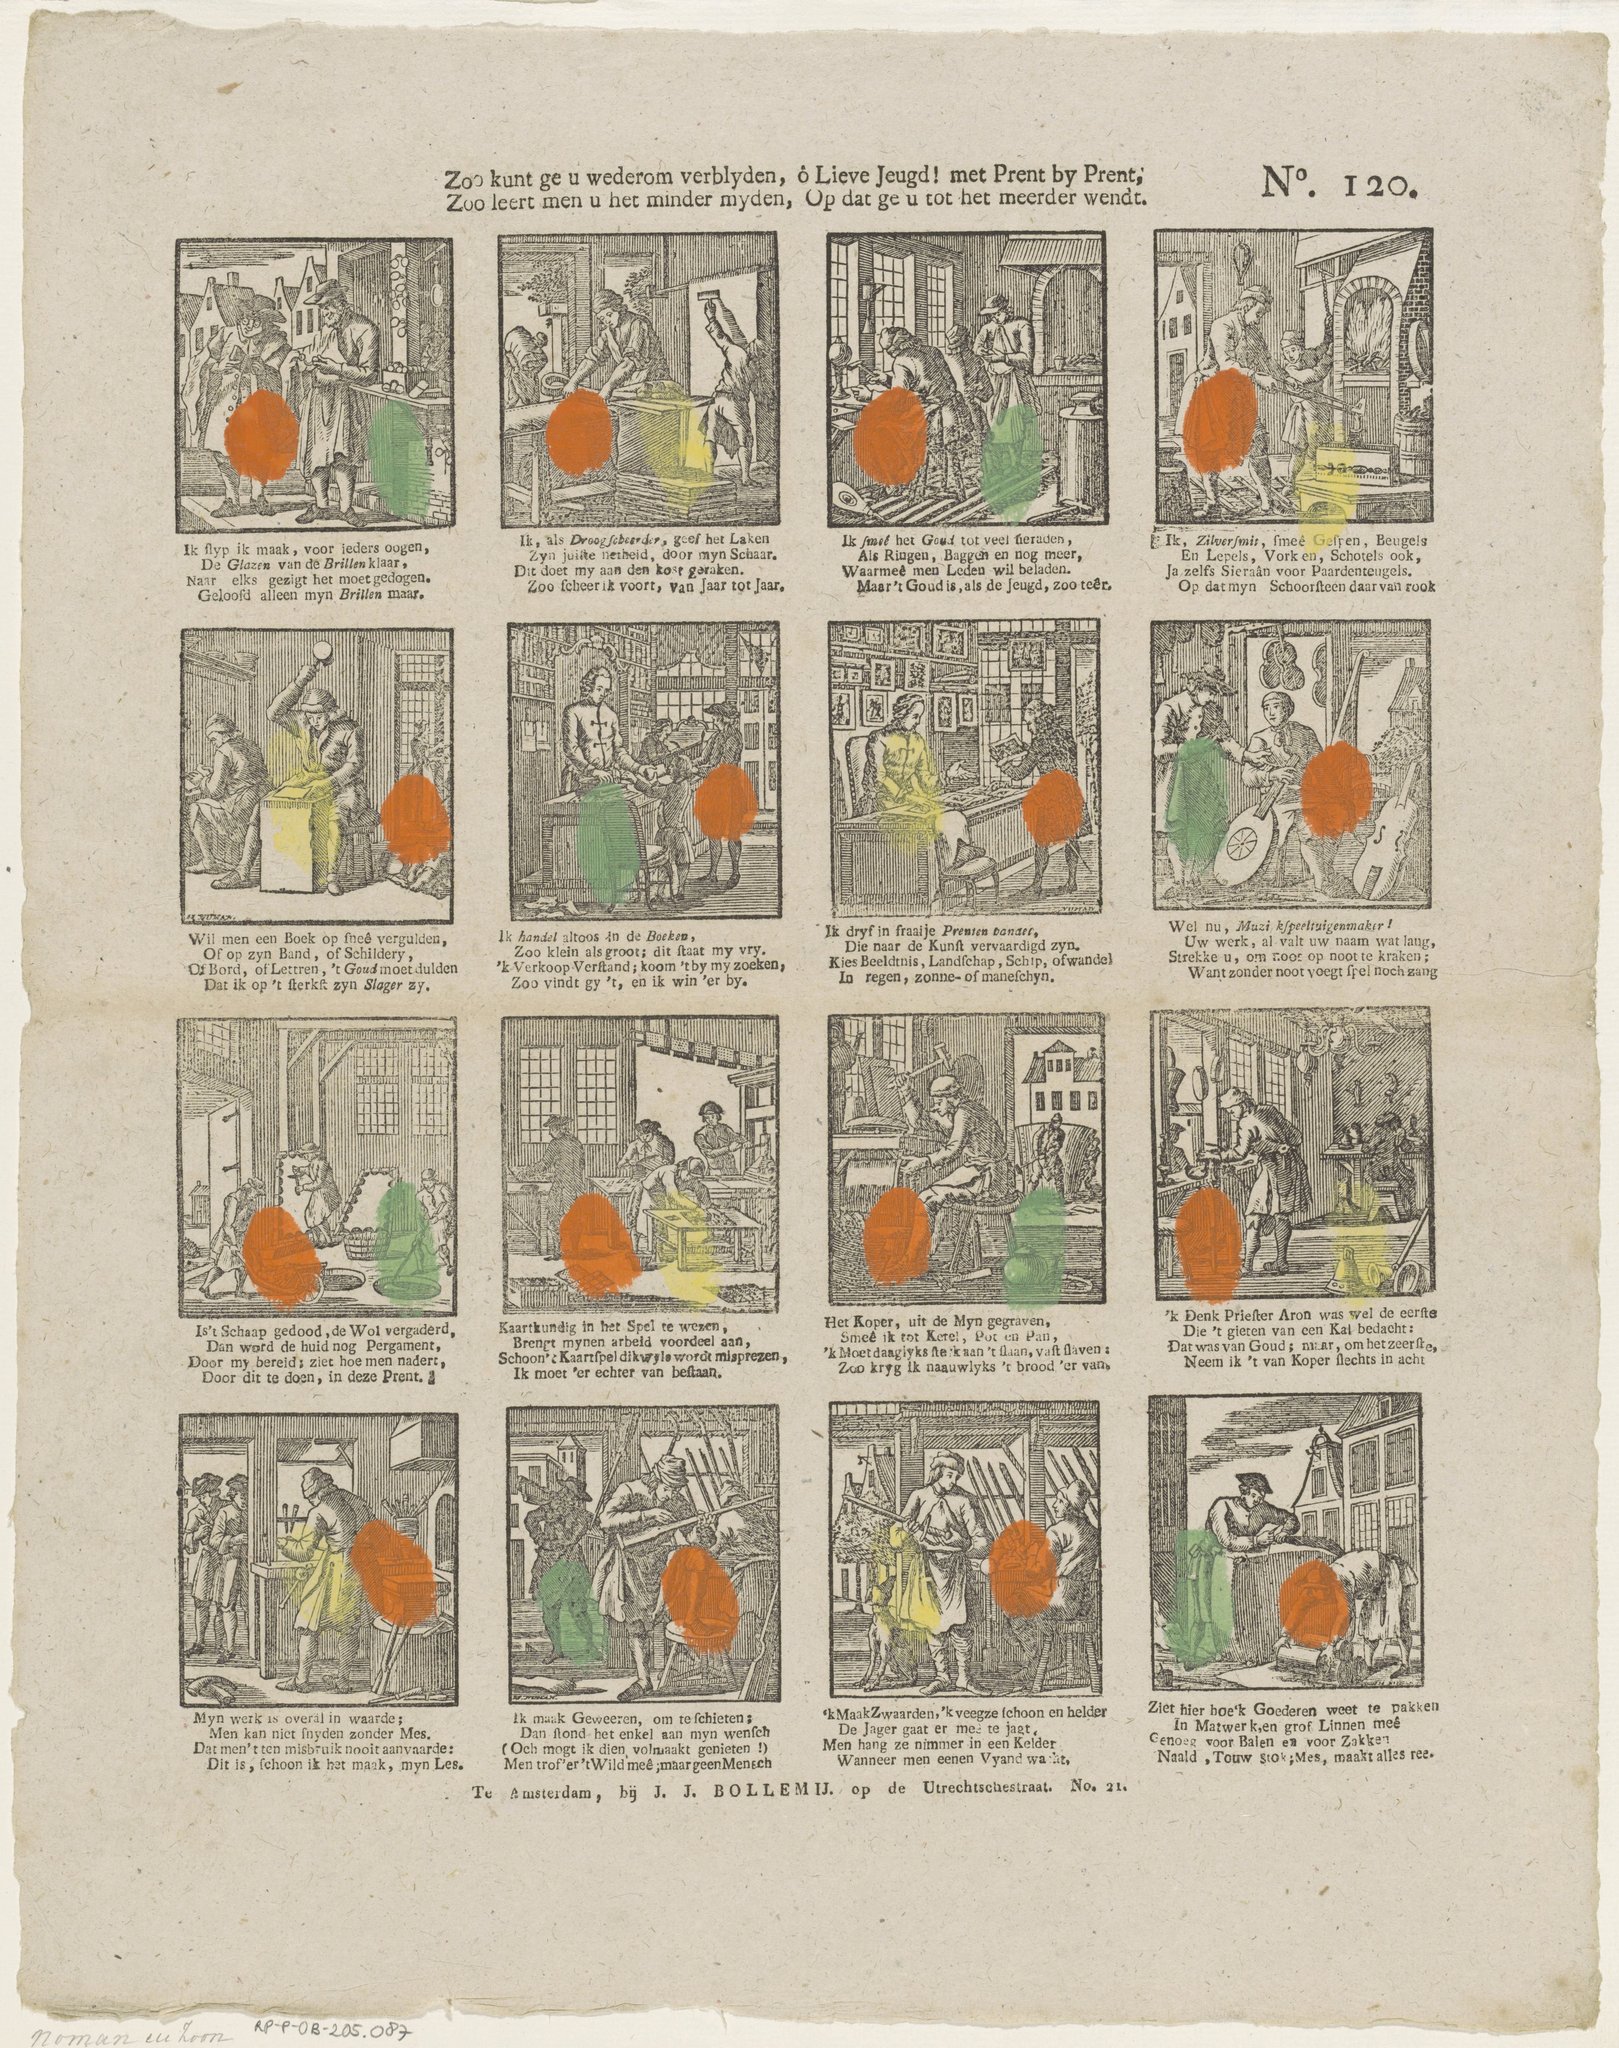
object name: popular print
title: Zoo kunt ge u wederom verblyden, ô lieve jeugd! met prent, / Zoo leert men u het minder myden, Op dat ge u tot het meerder wendt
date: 1806-1830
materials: paper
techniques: colour, letterpress printing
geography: amsterdam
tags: craft-production, skilled handiwork, jeweller, goldsmith, silversmith, street-trader, crafts and industries, merchant, salesman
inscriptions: collector's mark: Lugt 2760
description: Blad met 16 voorstellingen van ambachtsliedenen beroepen, zoals een brillenverkoper, een goudsmid en een gewerenmaker. Onder elke afbeelding een vierregelig vers. Genummerd rechtsboven: No. 120.